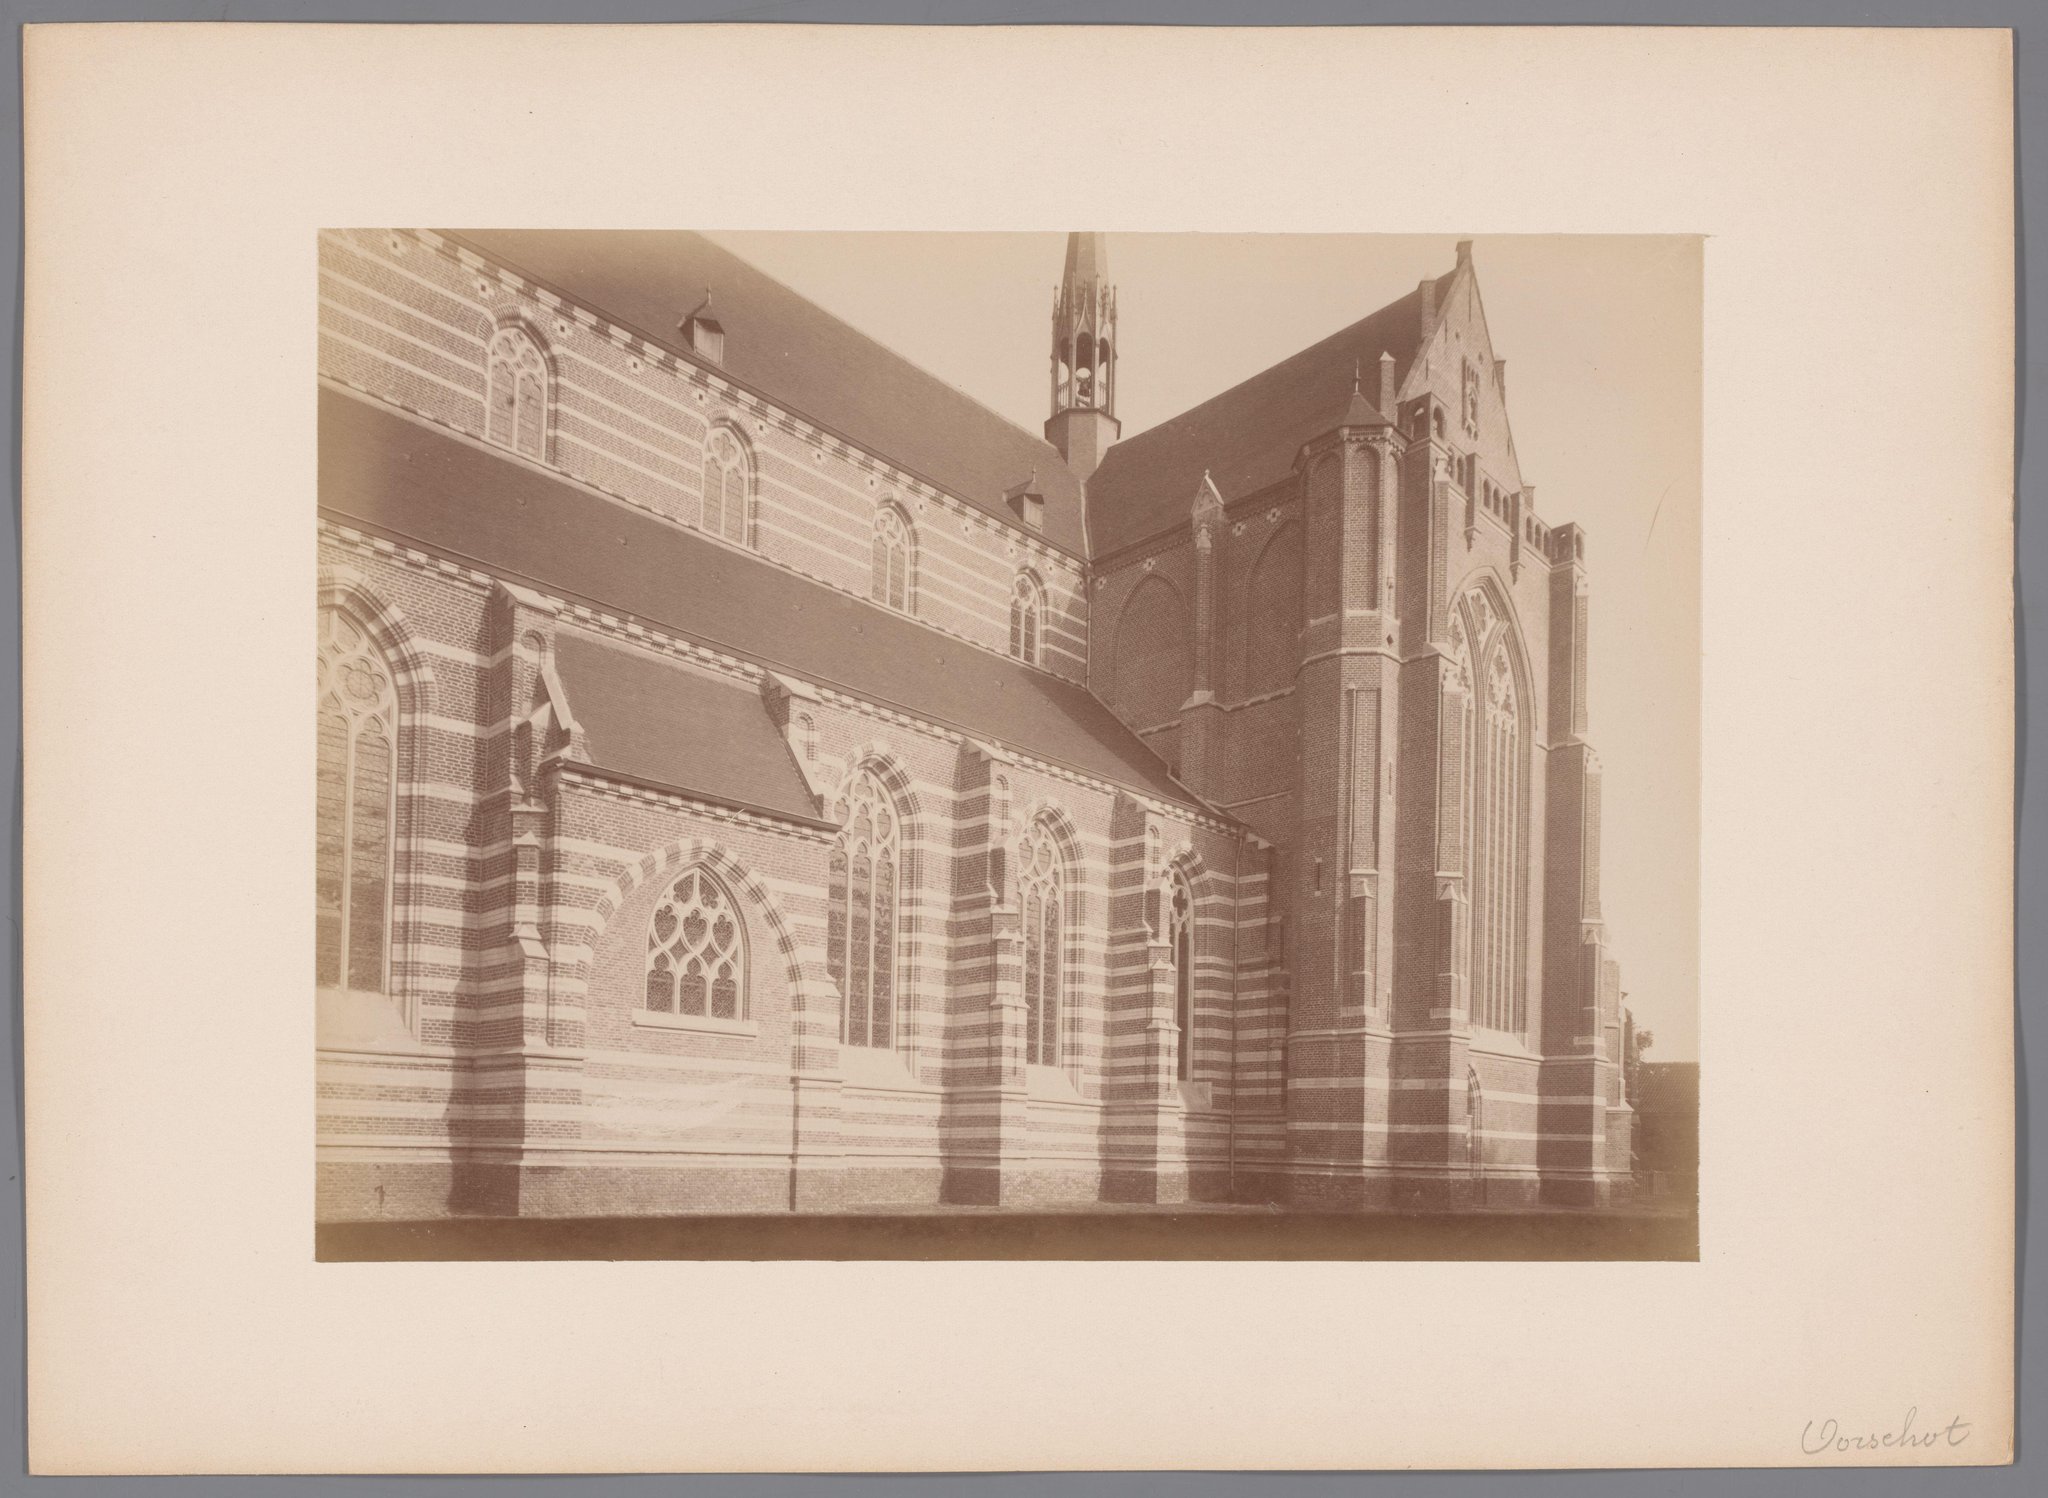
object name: photograph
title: Zuidzijde van de Sint-Pertrusbasiliek te Oirschot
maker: anoniem (monumentenzorg)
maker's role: fotograaf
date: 1890-1920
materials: cardboard, photographic support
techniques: albumen print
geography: oirschot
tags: church (exterior)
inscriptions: annotation: ‘Oorschot R.K. Kerk’, annotation: ‘Oorschot’